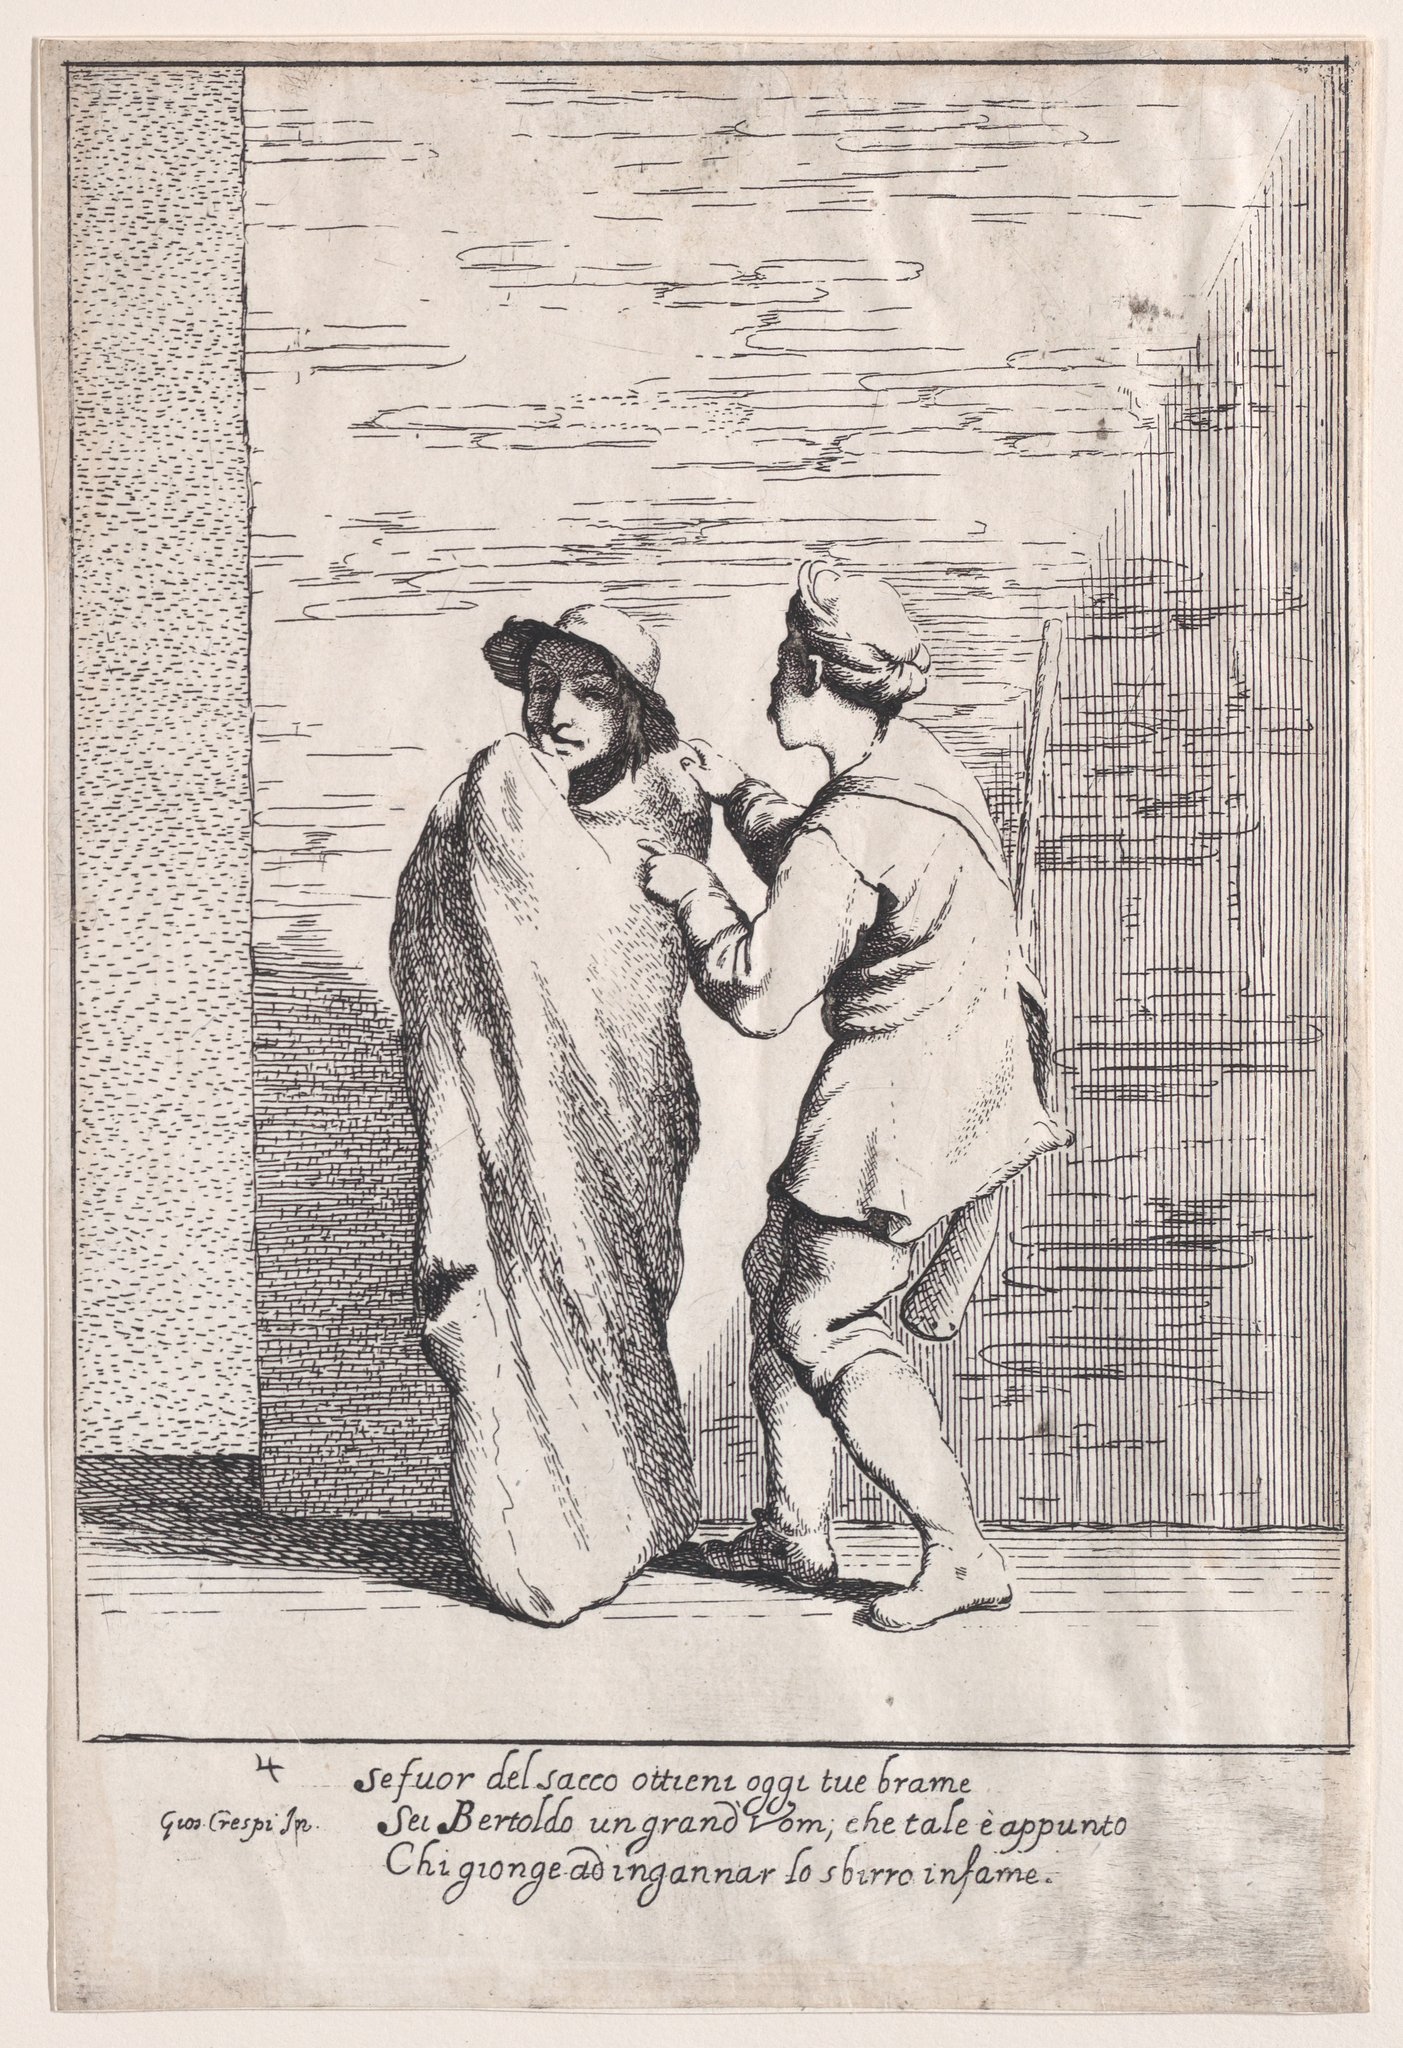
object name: print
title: Plate 4: Bertoldo stuffed in a sack, from "Bertoldo, Bertoldino, and Cacasenno"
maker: giuseppe maria crespi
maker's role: artist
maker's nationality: italian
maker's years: 1665-1747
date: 1705-1715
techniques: etching